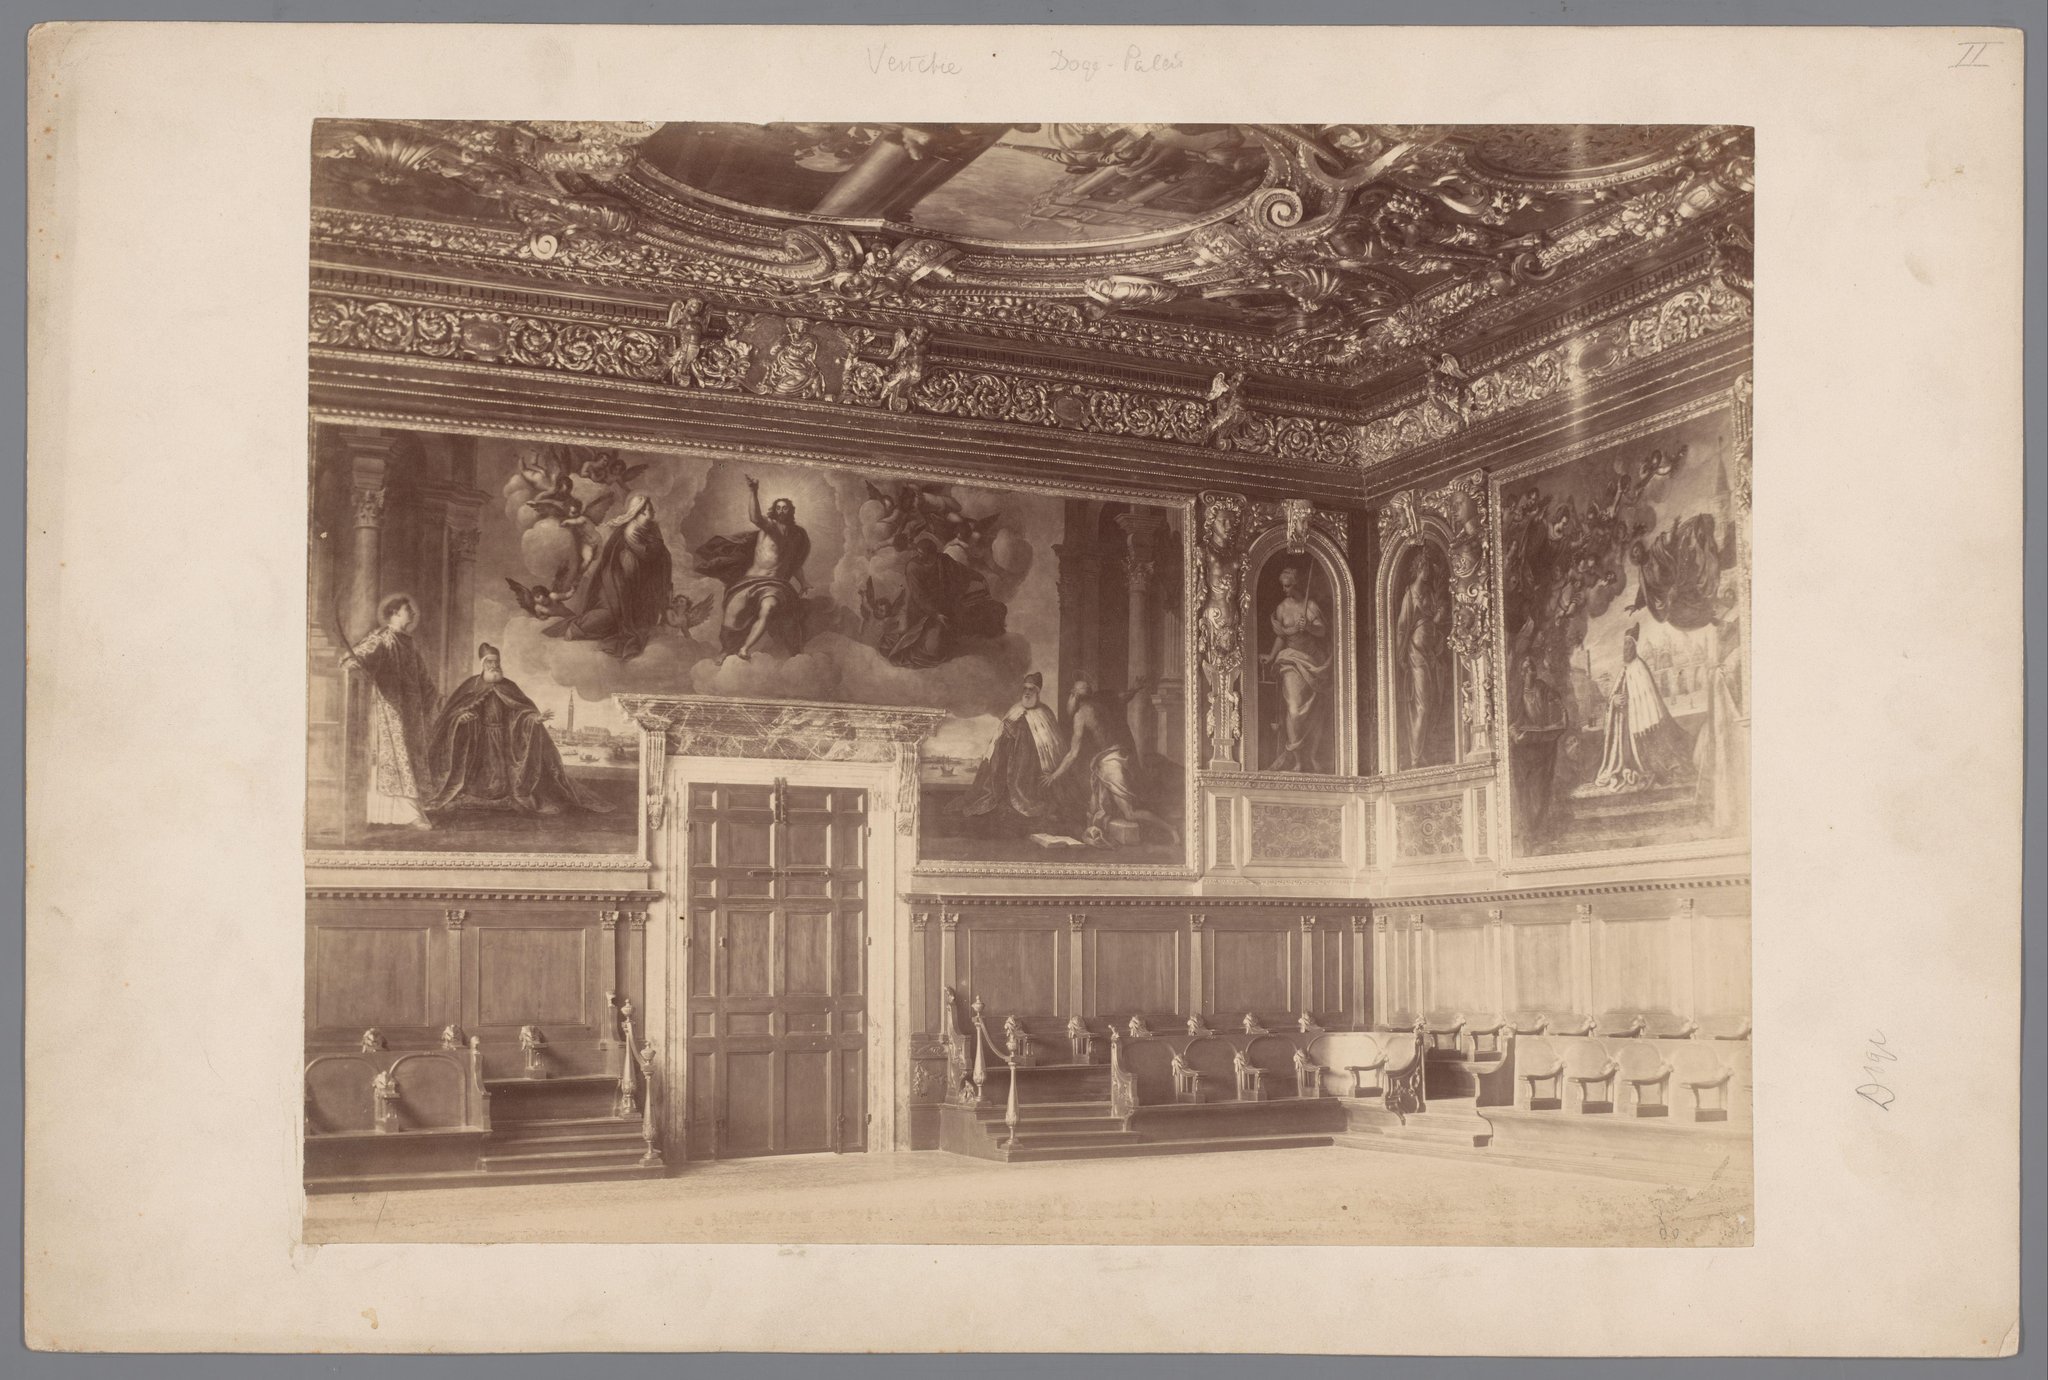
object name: photograph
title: Interieur van een zaal van het Dogepaleis te Venetië, Italië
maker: carlo ponti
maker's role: fotograaf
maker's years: 1820-1893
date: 1852-1893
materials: cardboard, paper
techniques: albumen print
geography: venice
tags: palace, interior of the house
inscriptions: inscription: ‘Venetie Doge Paleis’, number: ‘II’, inscription: ‘Doge’, collector's mark: ‘RIJKS SCHOOL VOOR KUNSTNIJVERHEID/ GROEP’, inscription: ‘Ponti (t)’